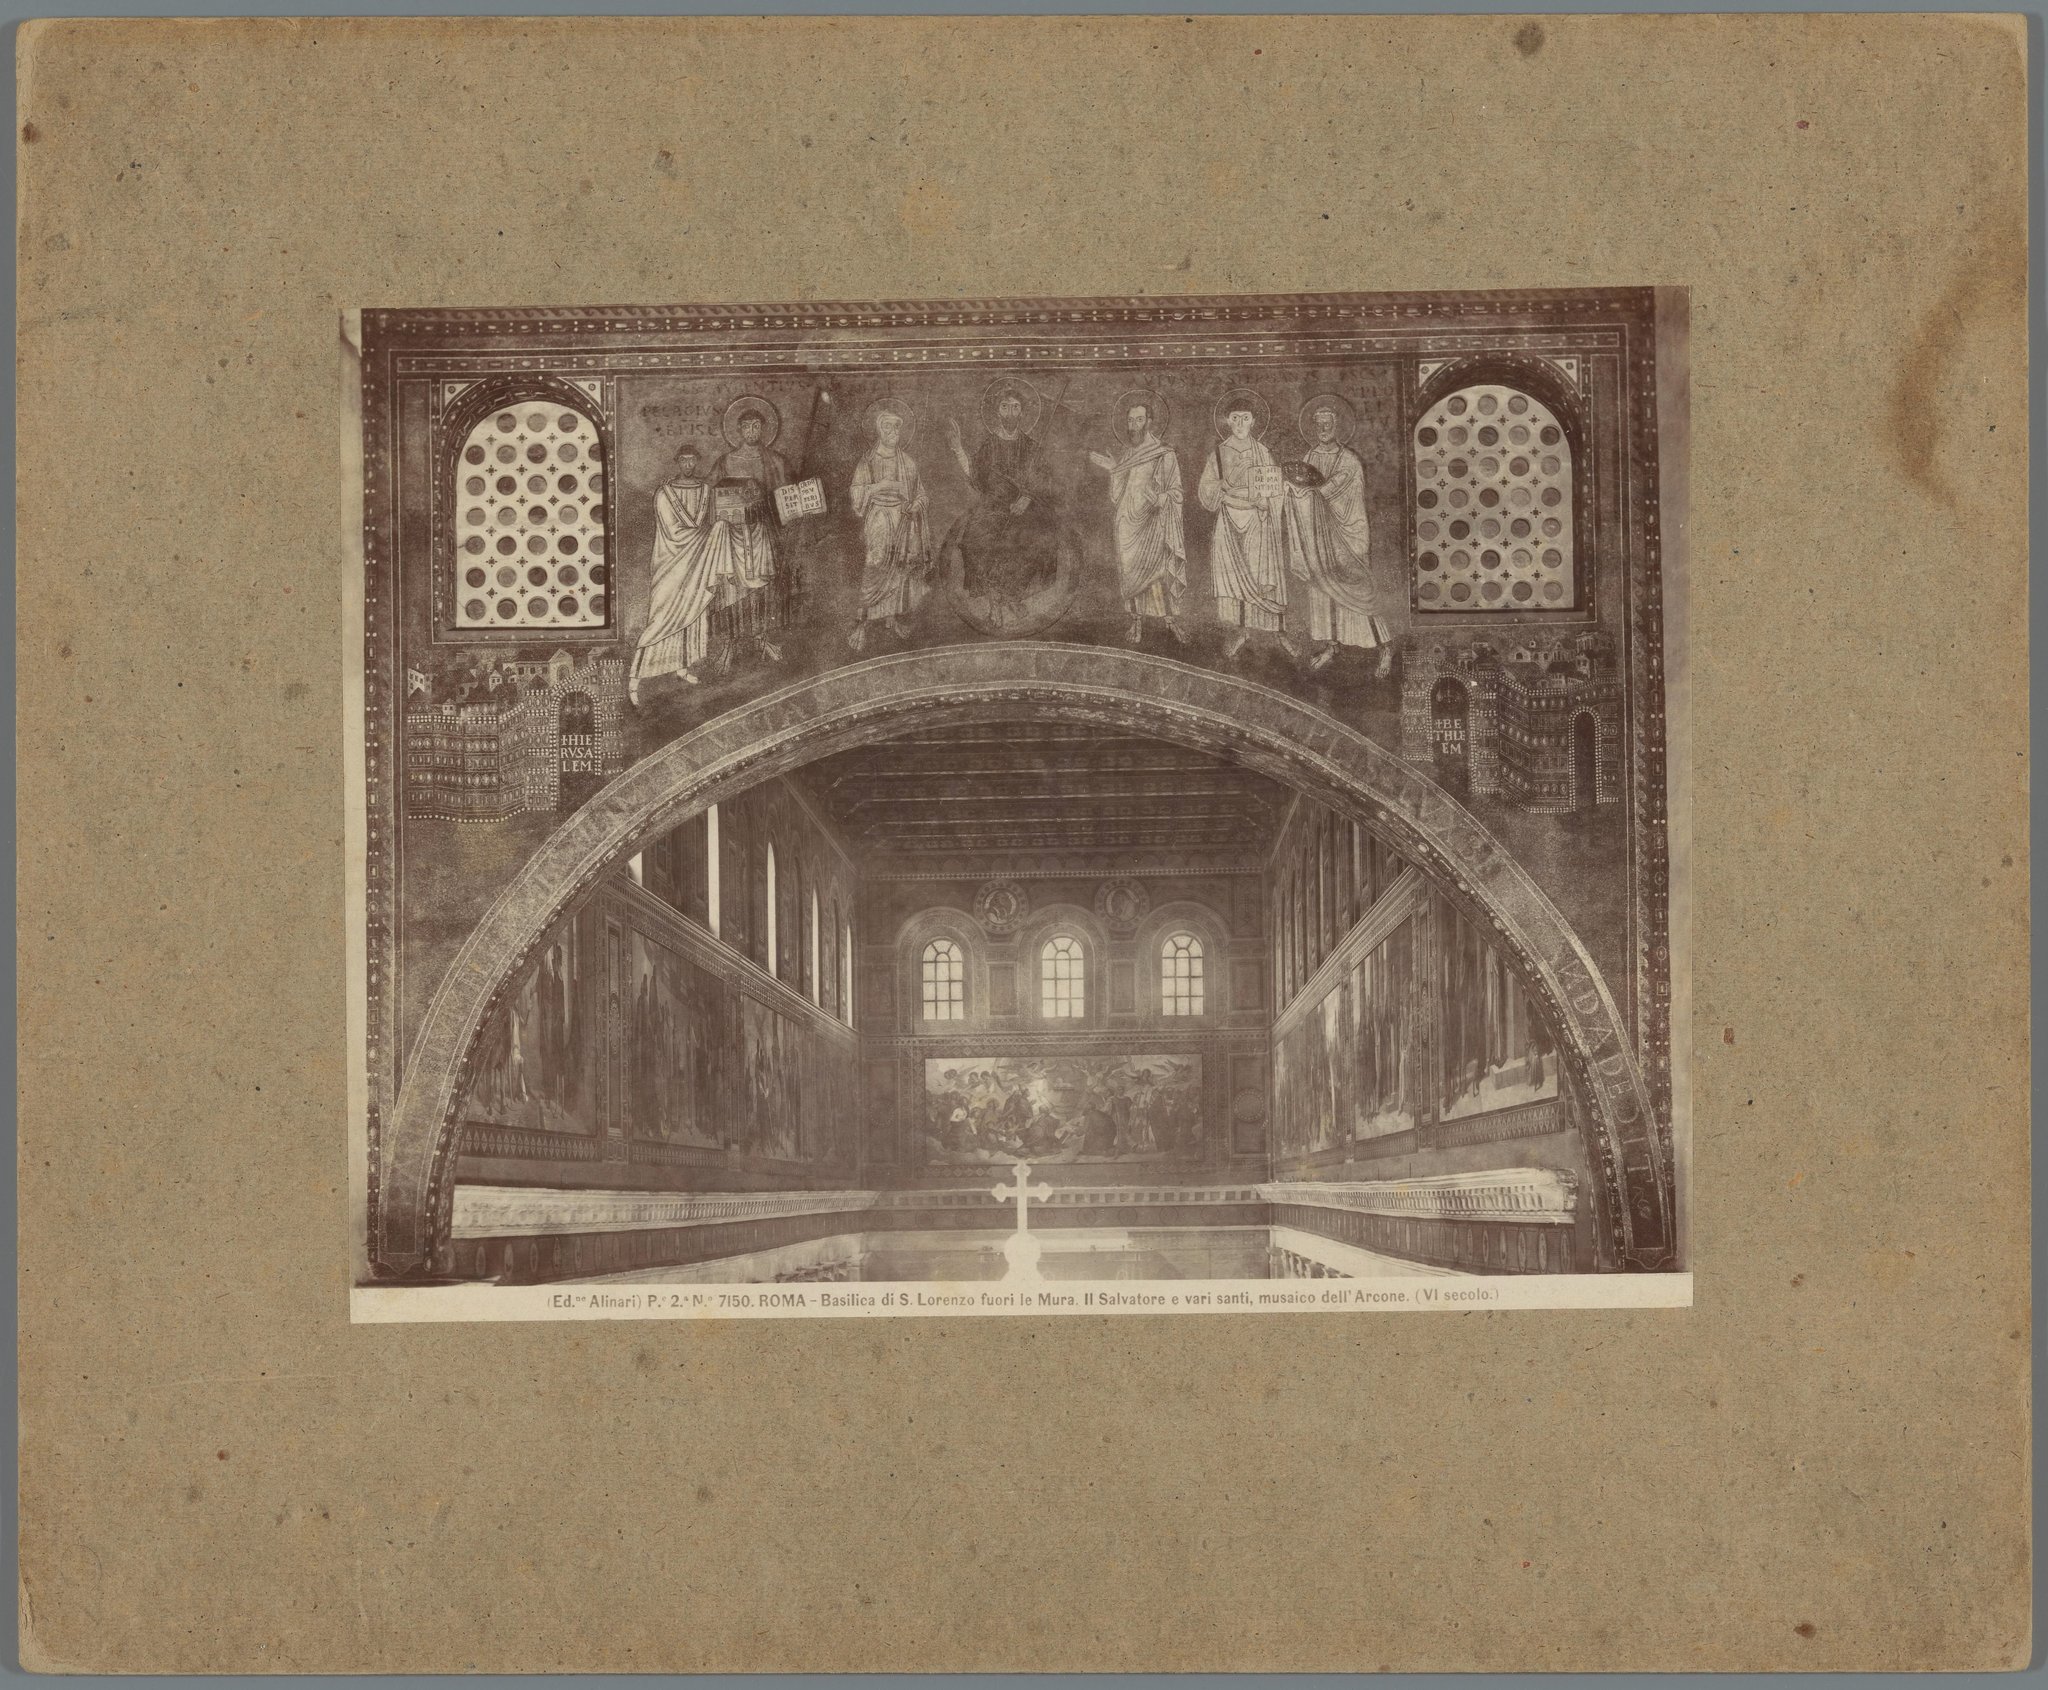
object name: photograph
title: Mozaïek op een boog tussen het schip en het koor in de Sint-Laurens buiten de Muren te Rome, voorstellend Christus en meerdere heiligen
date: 1875-1900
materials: cardboard, photographic support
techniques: albumen print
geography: sint-laurens buiten de muren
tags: interior of church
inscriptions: collector's mark: Lugt 3937, inscription: ‘S.K. 31.’, number: ‘P.e 2.a N.o 7150.’